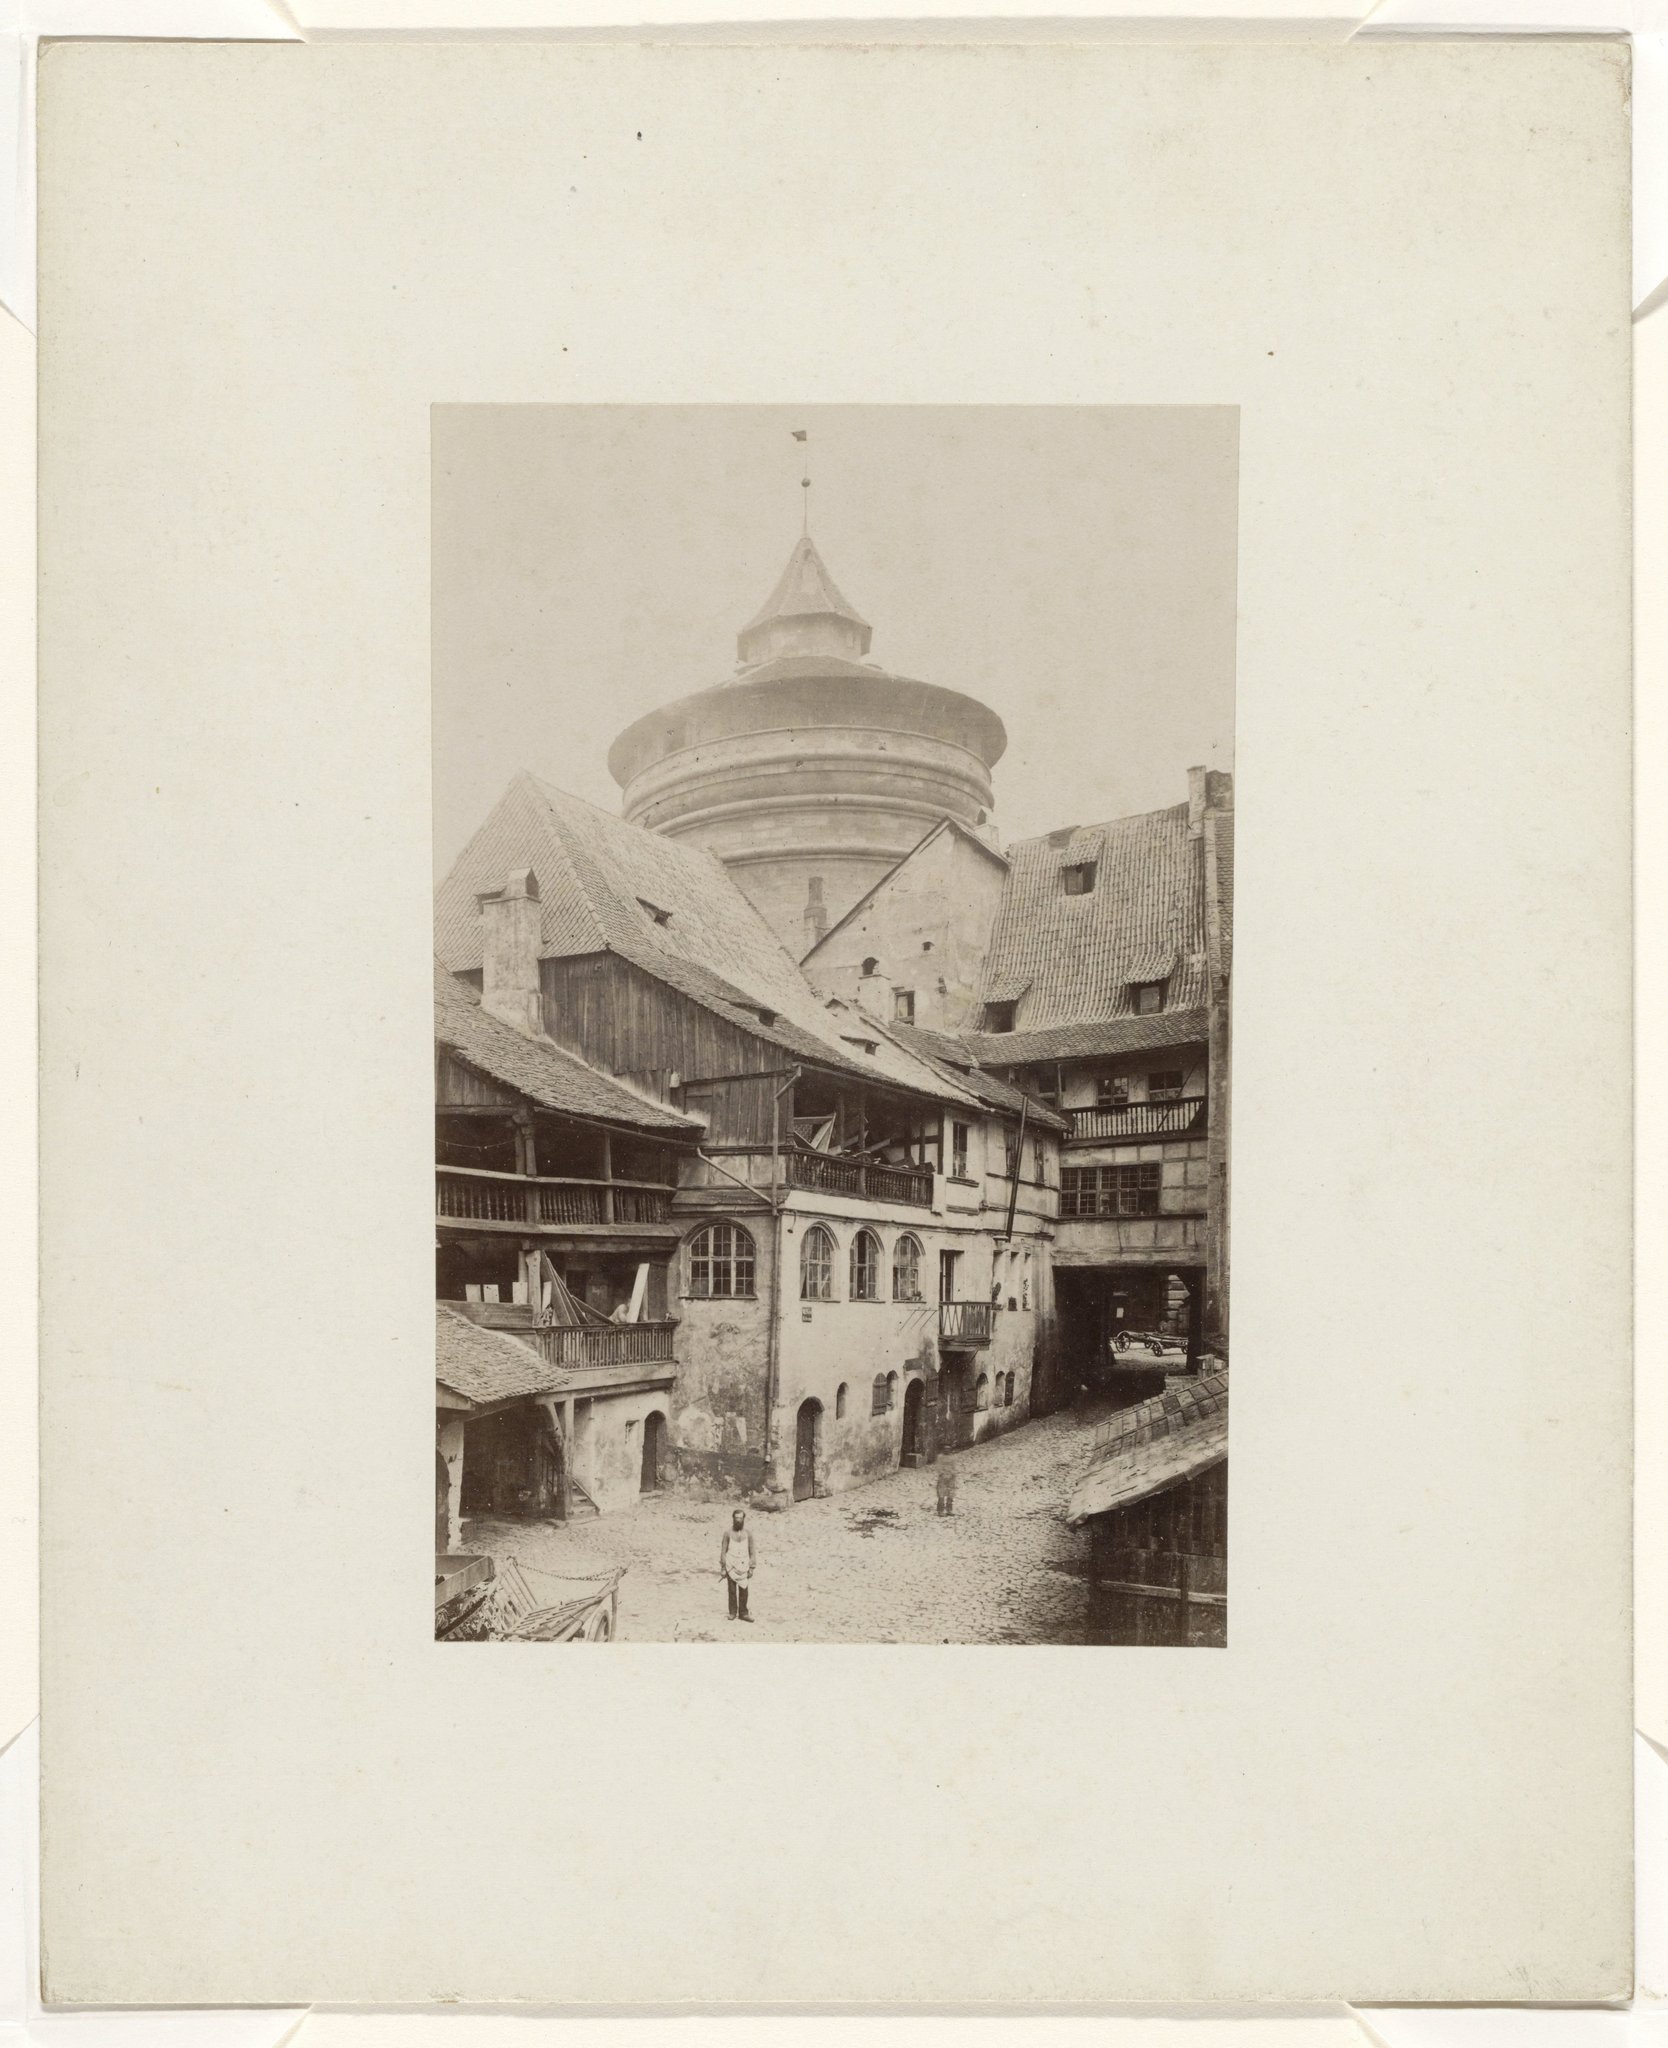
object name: photograph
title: Straatgezicht in Neurenberg met toren van de stadsmuur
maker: Anonymous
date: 1860-1890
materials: cardboard, paper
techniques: albumen print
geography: nuremberg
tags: city-walls, street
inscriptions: inscription: ‘Nürnberg’